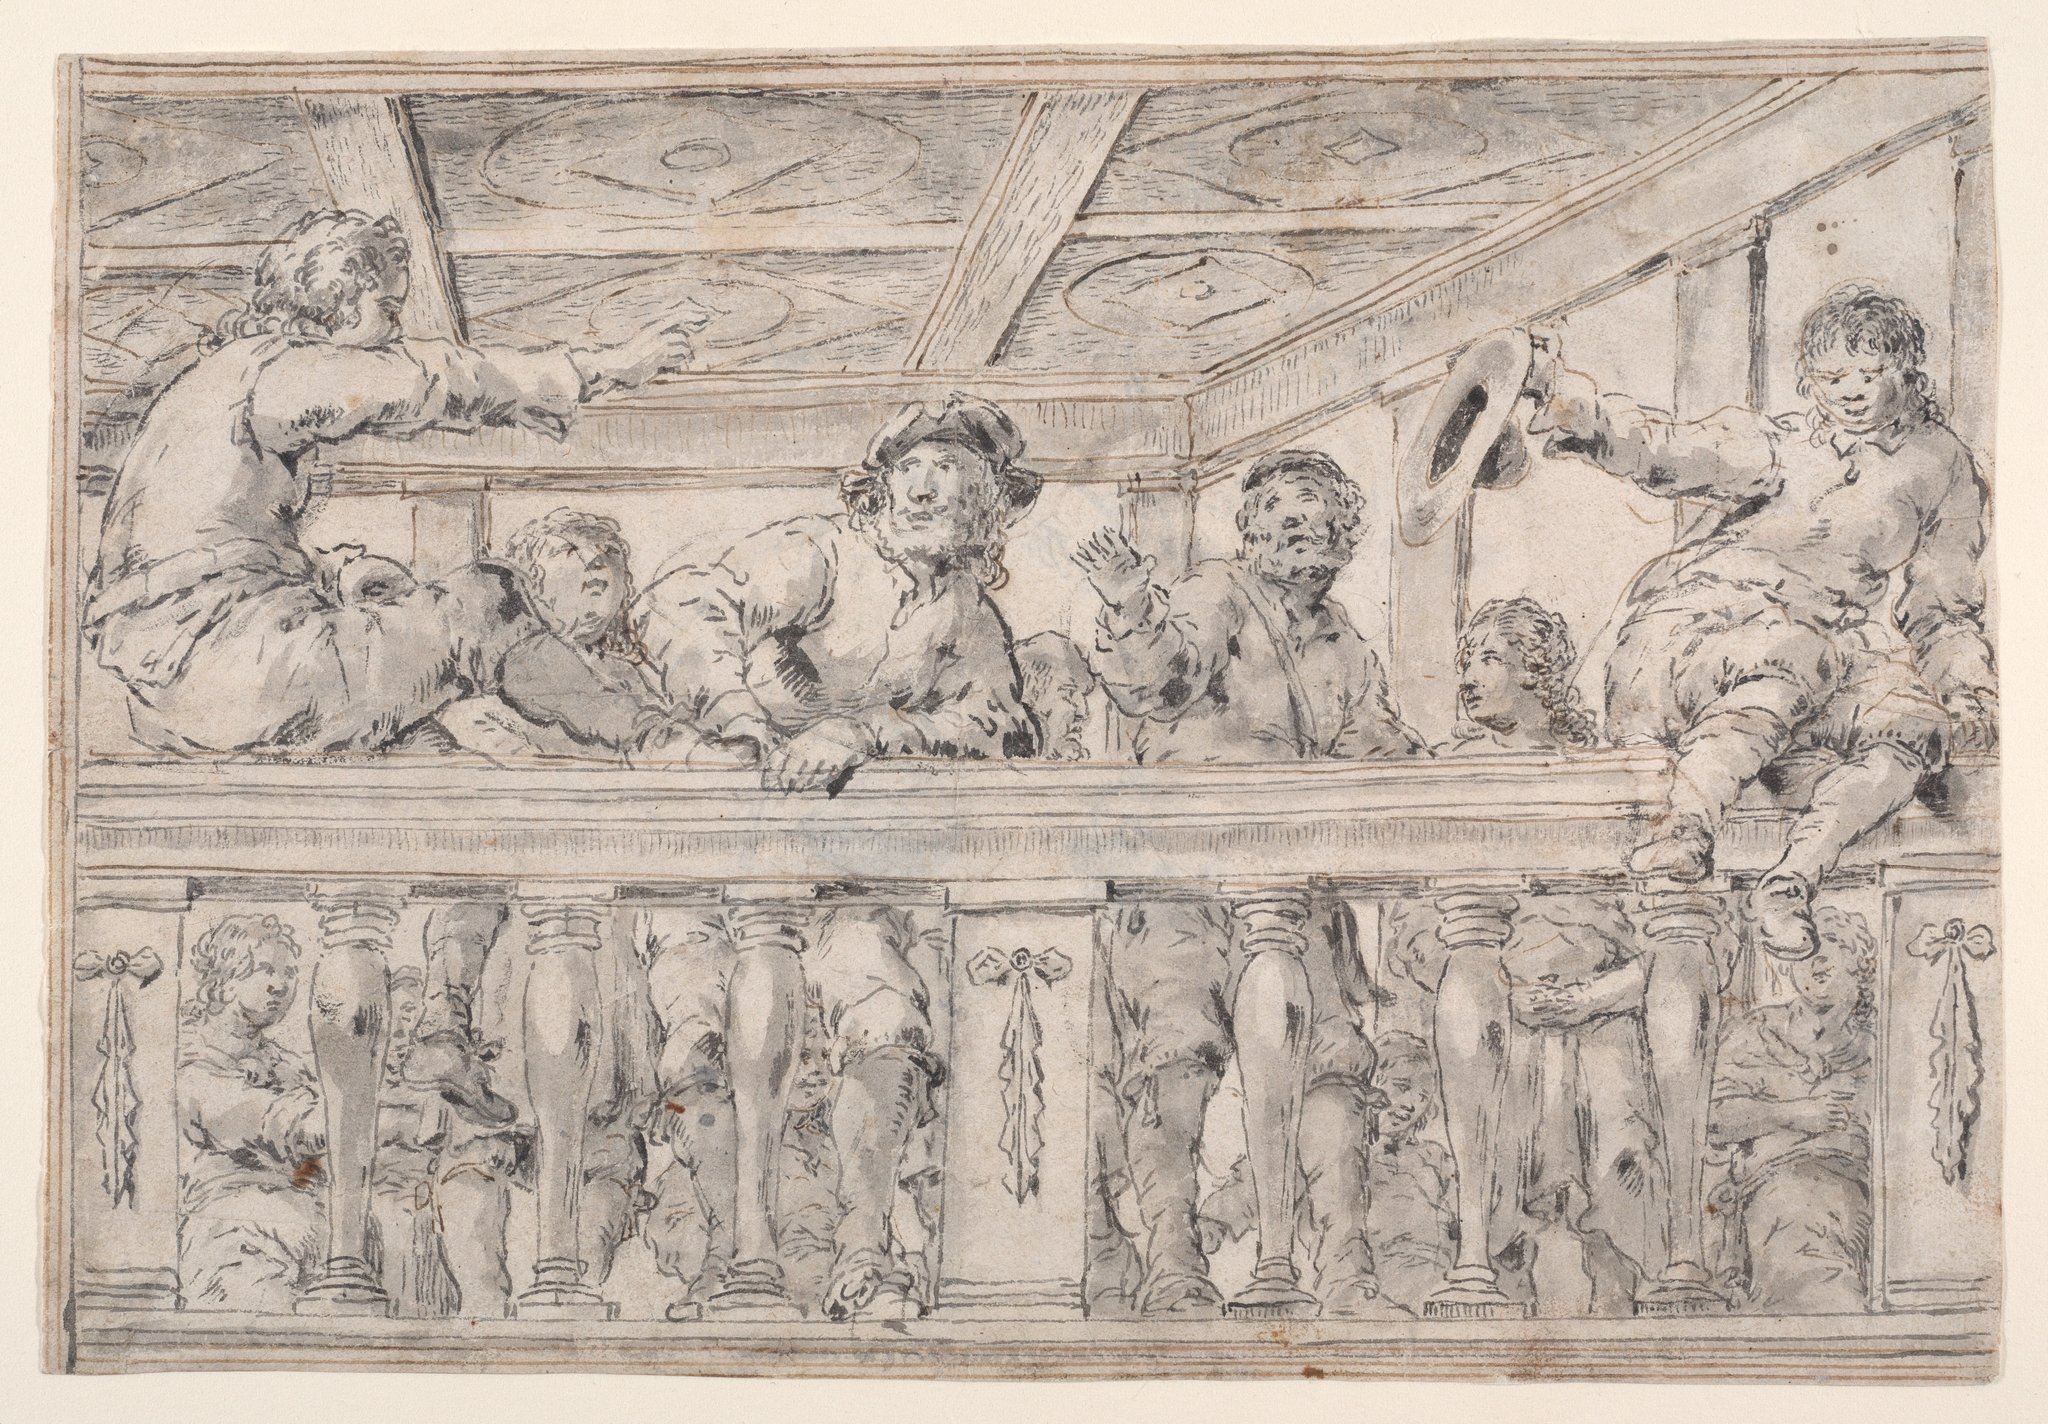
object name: drawing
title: Men on a Balcony (recto); Old Man Pointing to a Book Held by a Boy (verso)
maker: leonaert bramer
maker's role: artist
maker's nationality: dutch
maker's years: 1596-1674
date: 1634-1666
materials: chalk, ink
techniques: brush, pen, wash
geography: netherlands